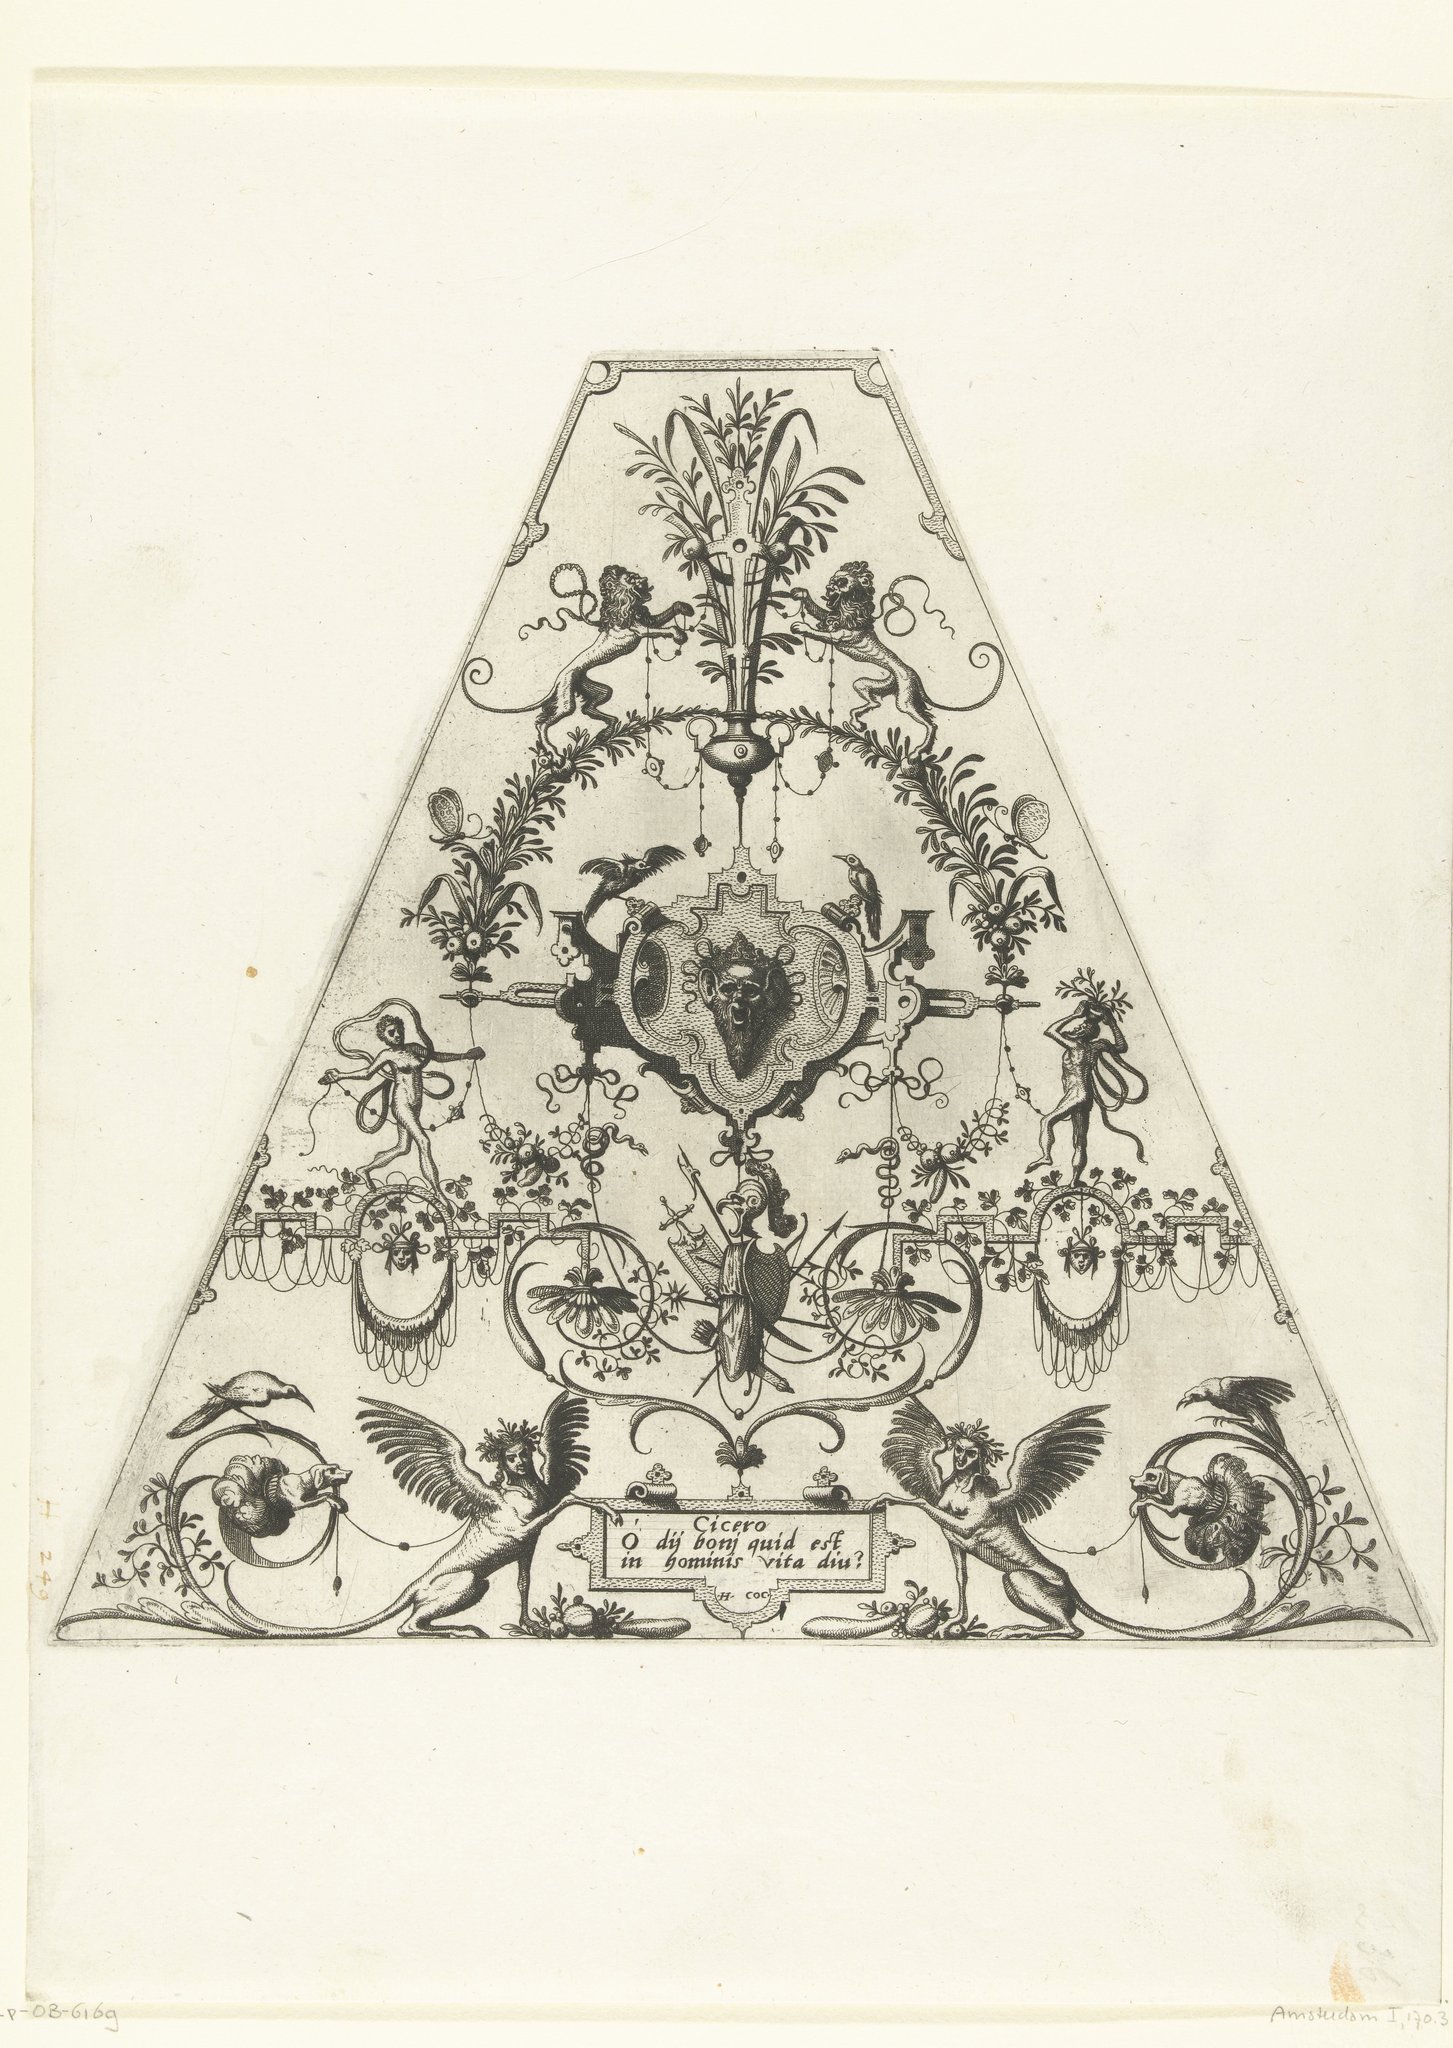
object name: ornament print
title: Trapeziumvormige vlakdecoratie met citaat van Cicero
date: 1564-1565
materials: paper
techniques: etching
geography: netherlands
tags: trophy, i.e.: decorative arrangement of symbolic or typical objects ~ ornament, sphinx (lion/woman); 'sfinge' (ripa), ornament ~ cartouche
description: Citaat van Cicero (O dii boni quid est / in hominis vita diu), geflankeerd door twee sfinxen. Hun staarten lopen uit in de kelk van een bloem, waaruit een hond springt. In het midden hangt een wapentrofee aan een cartouche met een mascaron Uit serie van 4 bladen.